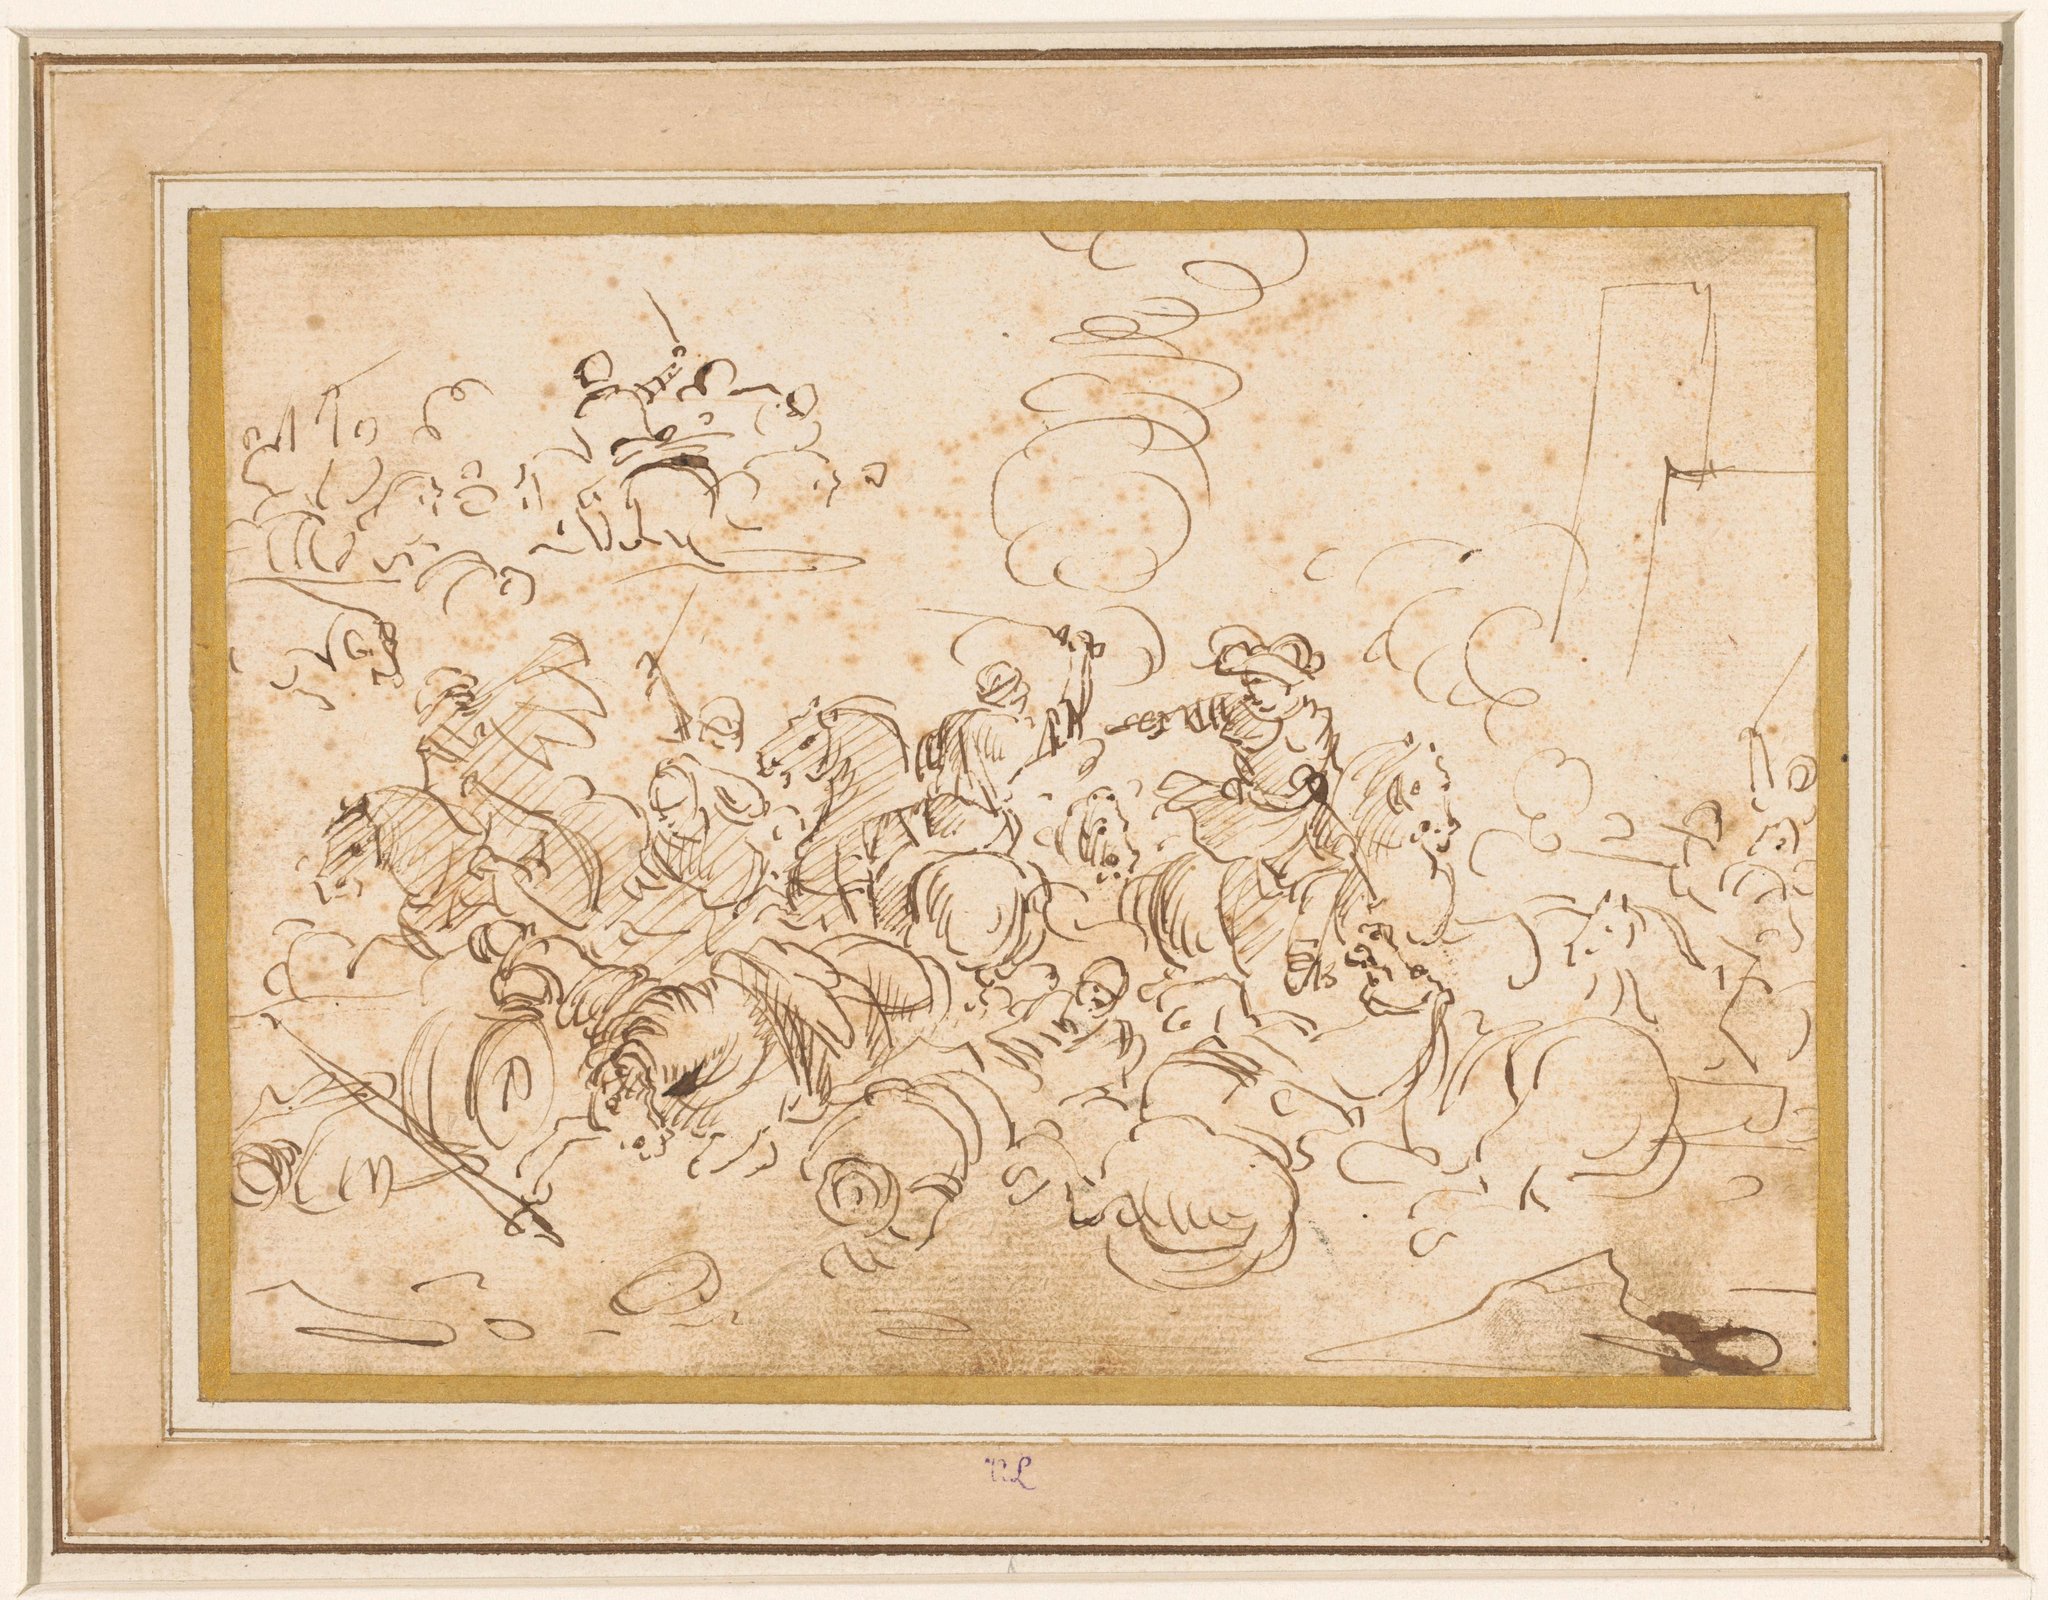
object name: drawing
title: Ruitergevecht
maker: jacques courtois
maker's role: painter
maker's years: 1621-1676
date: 1631-1676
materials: ink, paper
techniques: pen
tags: battle (+ cavalry, horsemen)